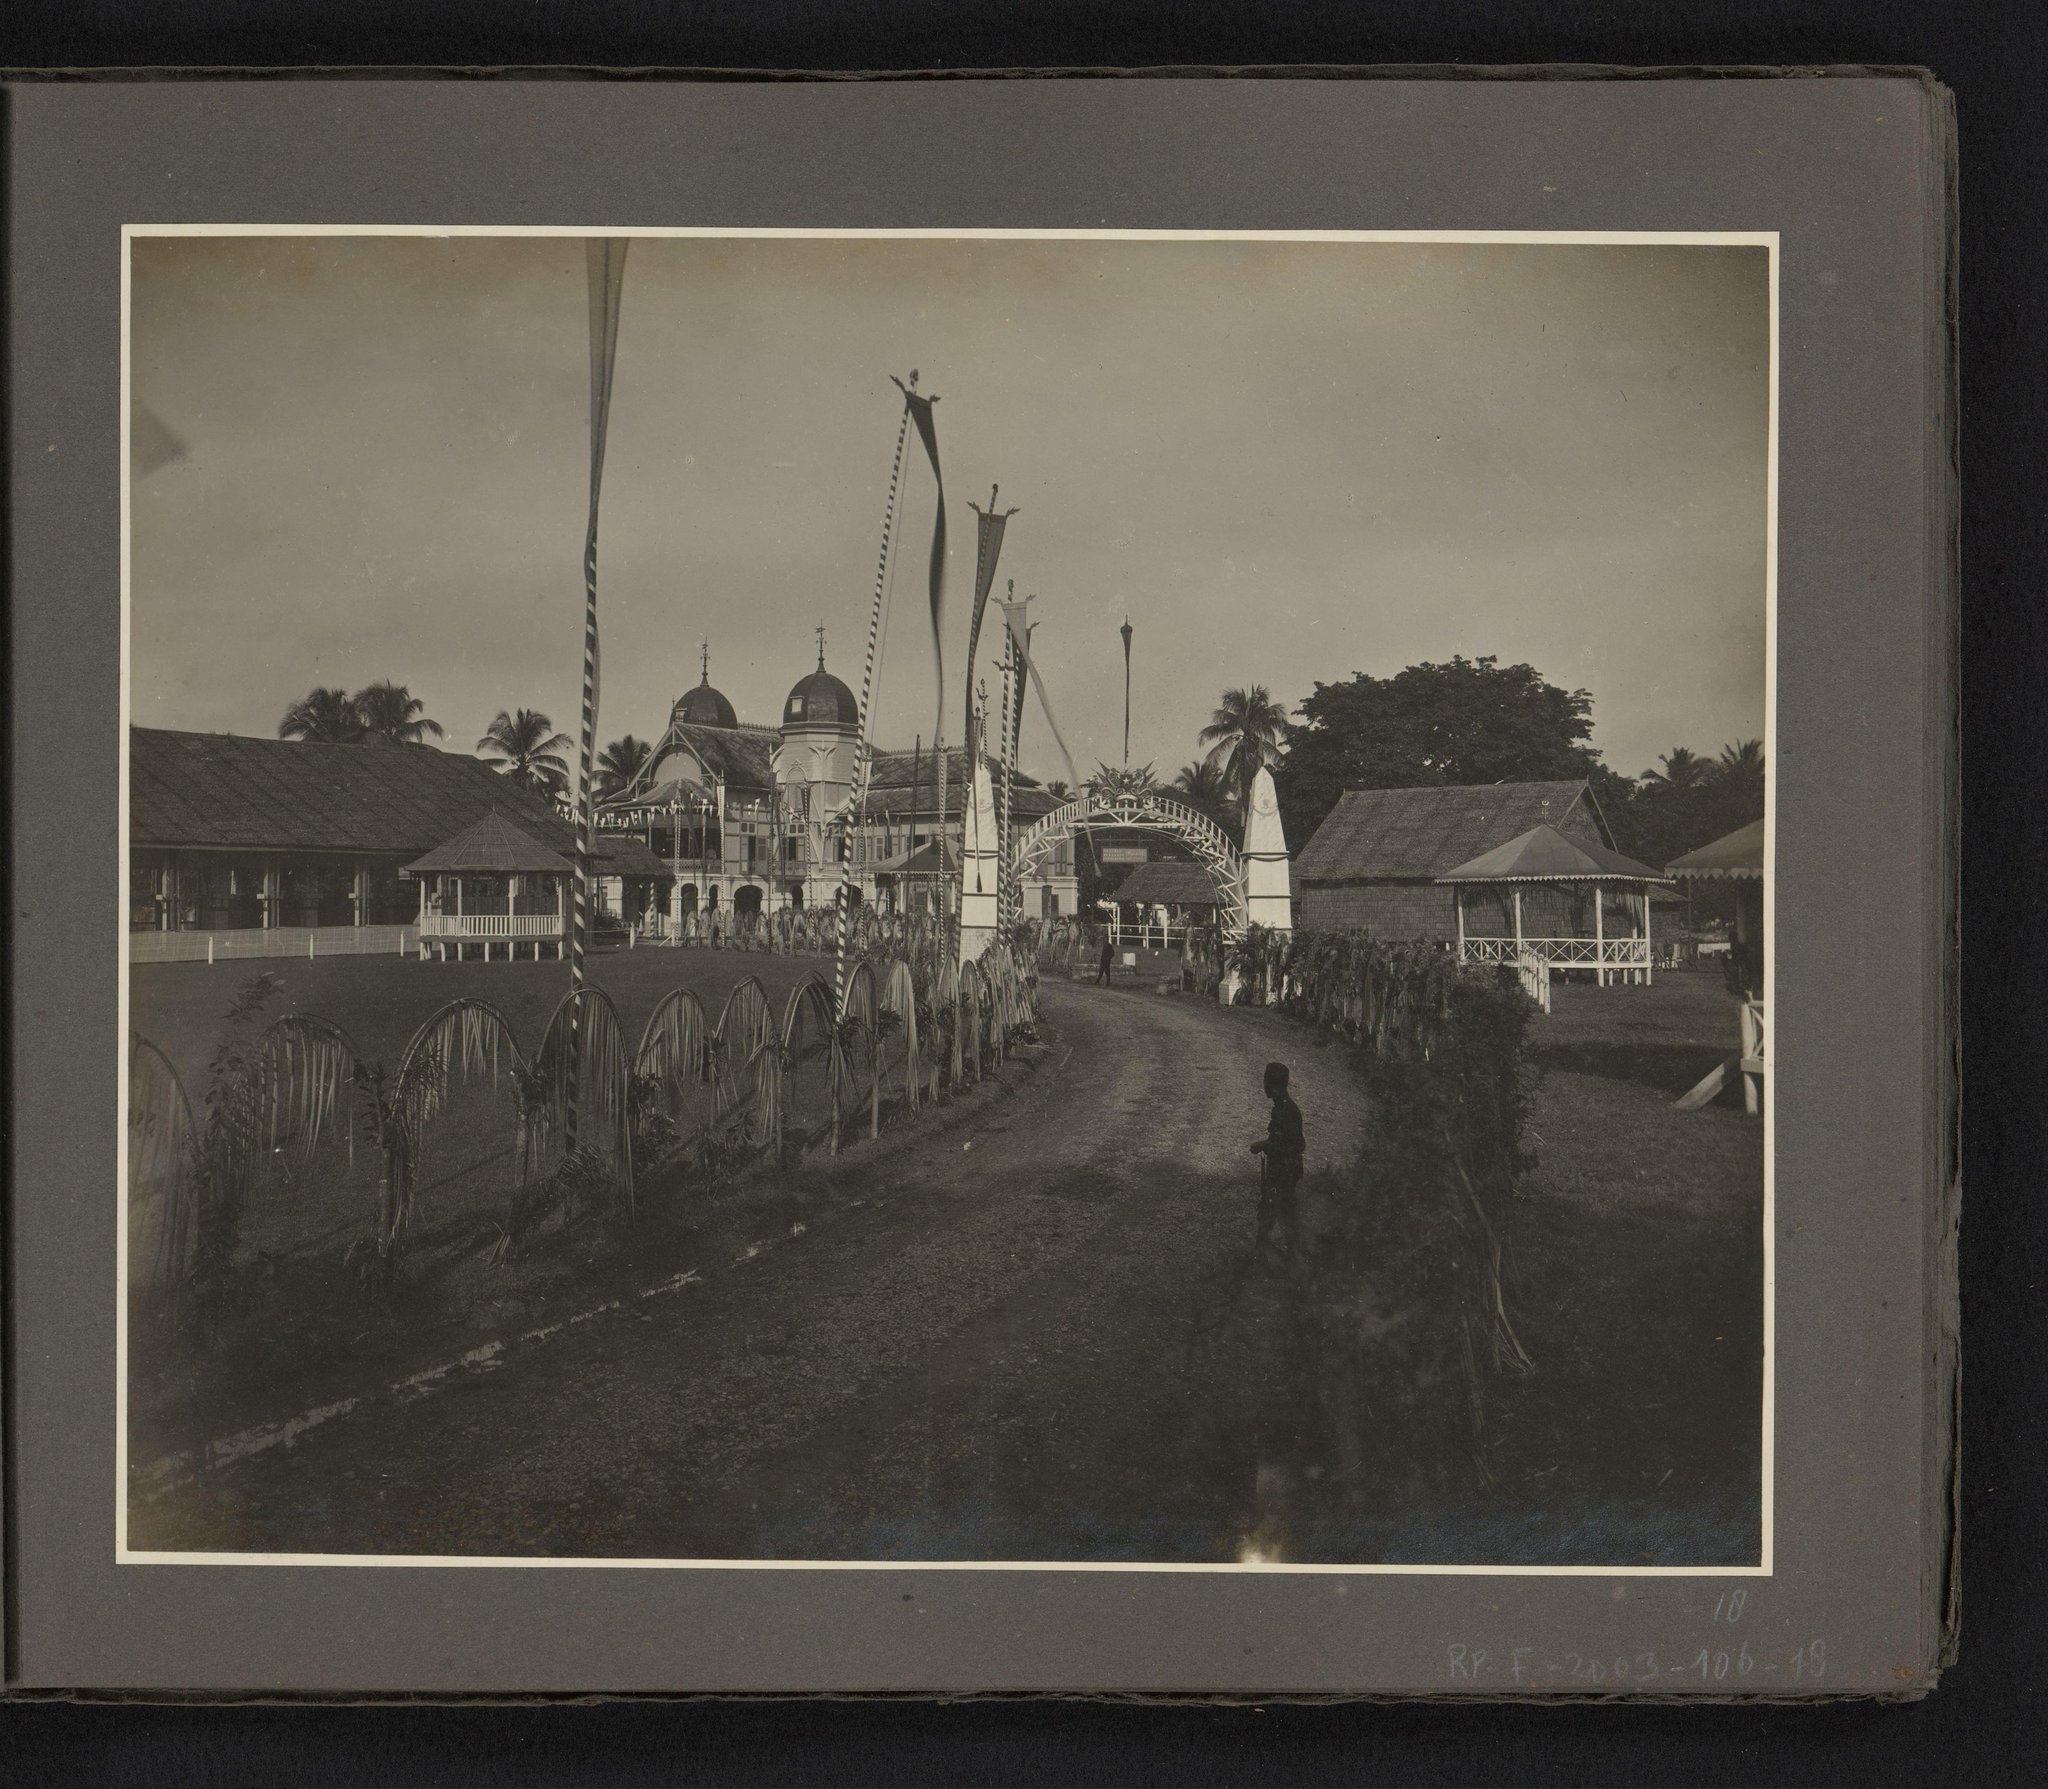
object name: album leaf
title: Toegangsweg met versieringen naar het paleis van de Sultan van Langkat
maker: Anonymous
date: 1919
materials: photographic support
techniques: gelatin silver print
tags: palace, road, path, gate, entrance, sumatra